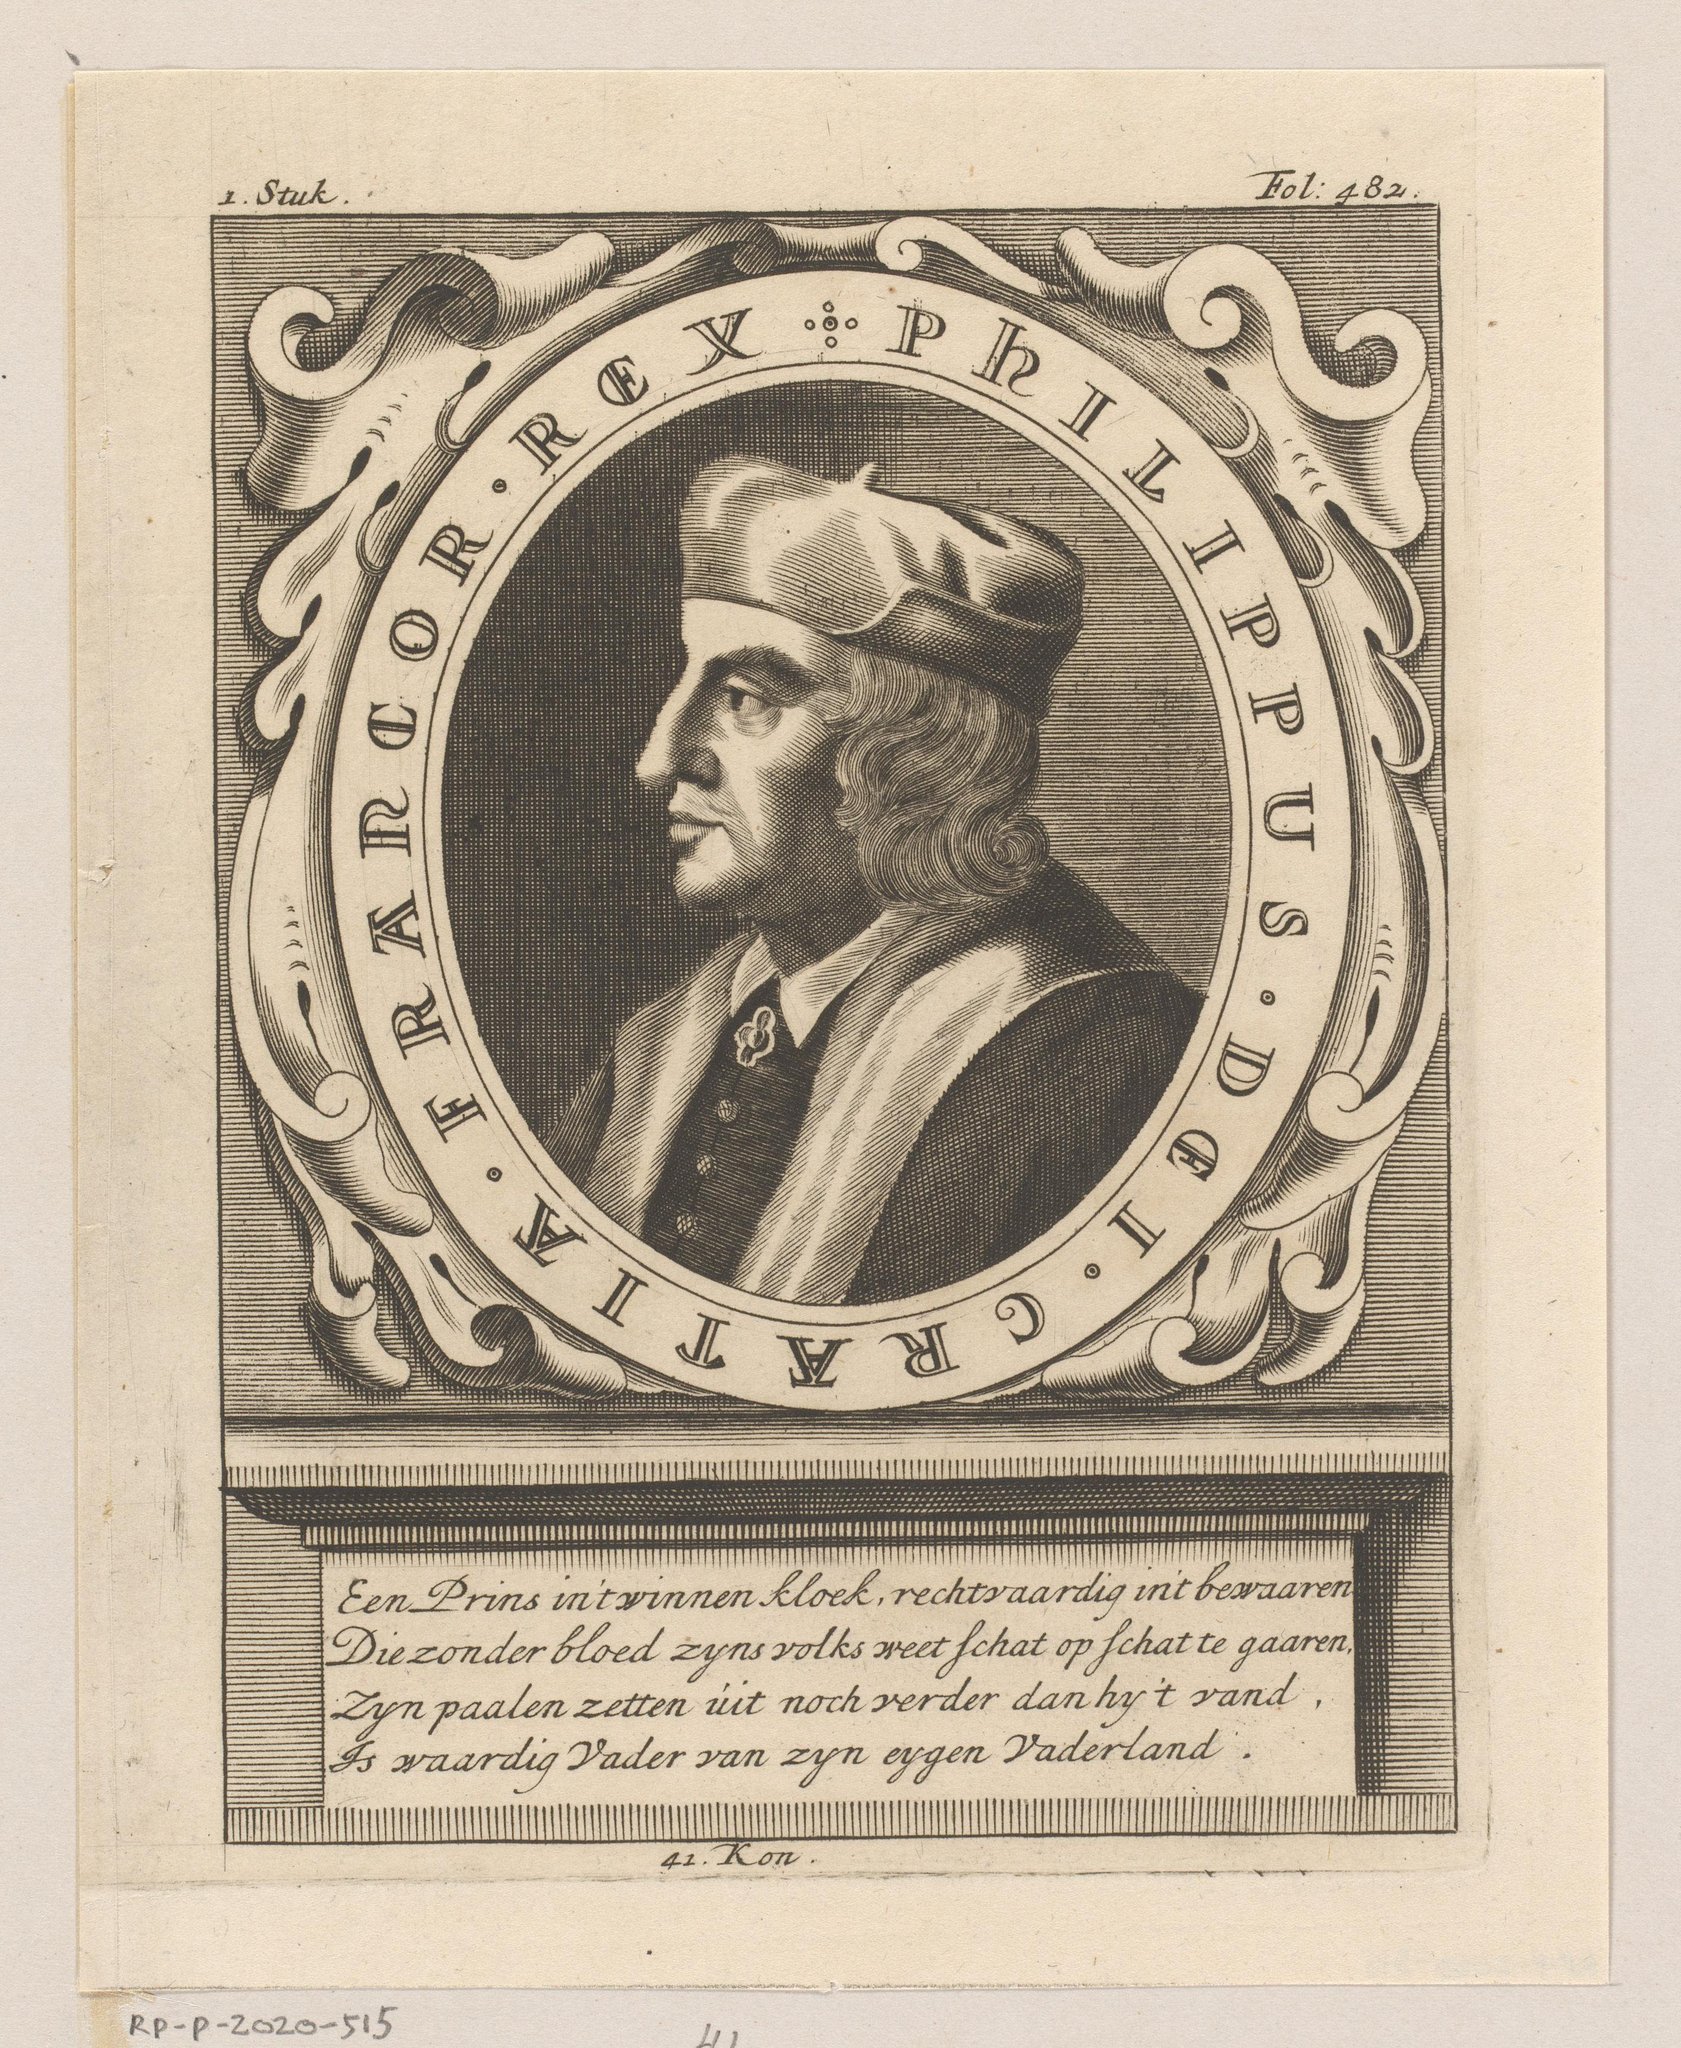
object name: print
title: Philippus dei gratia Francor rex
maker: Anonymous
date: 1685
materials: paper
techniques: engraving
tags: paris, historical persons, king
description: Prent gebruikt in: Eudes de Mézeray, François. Chronyk van Vrankryk. 6 dln. Amsterdam: Jan Bouman en Timotheum ten Hoorn, 1685, dl. 2.